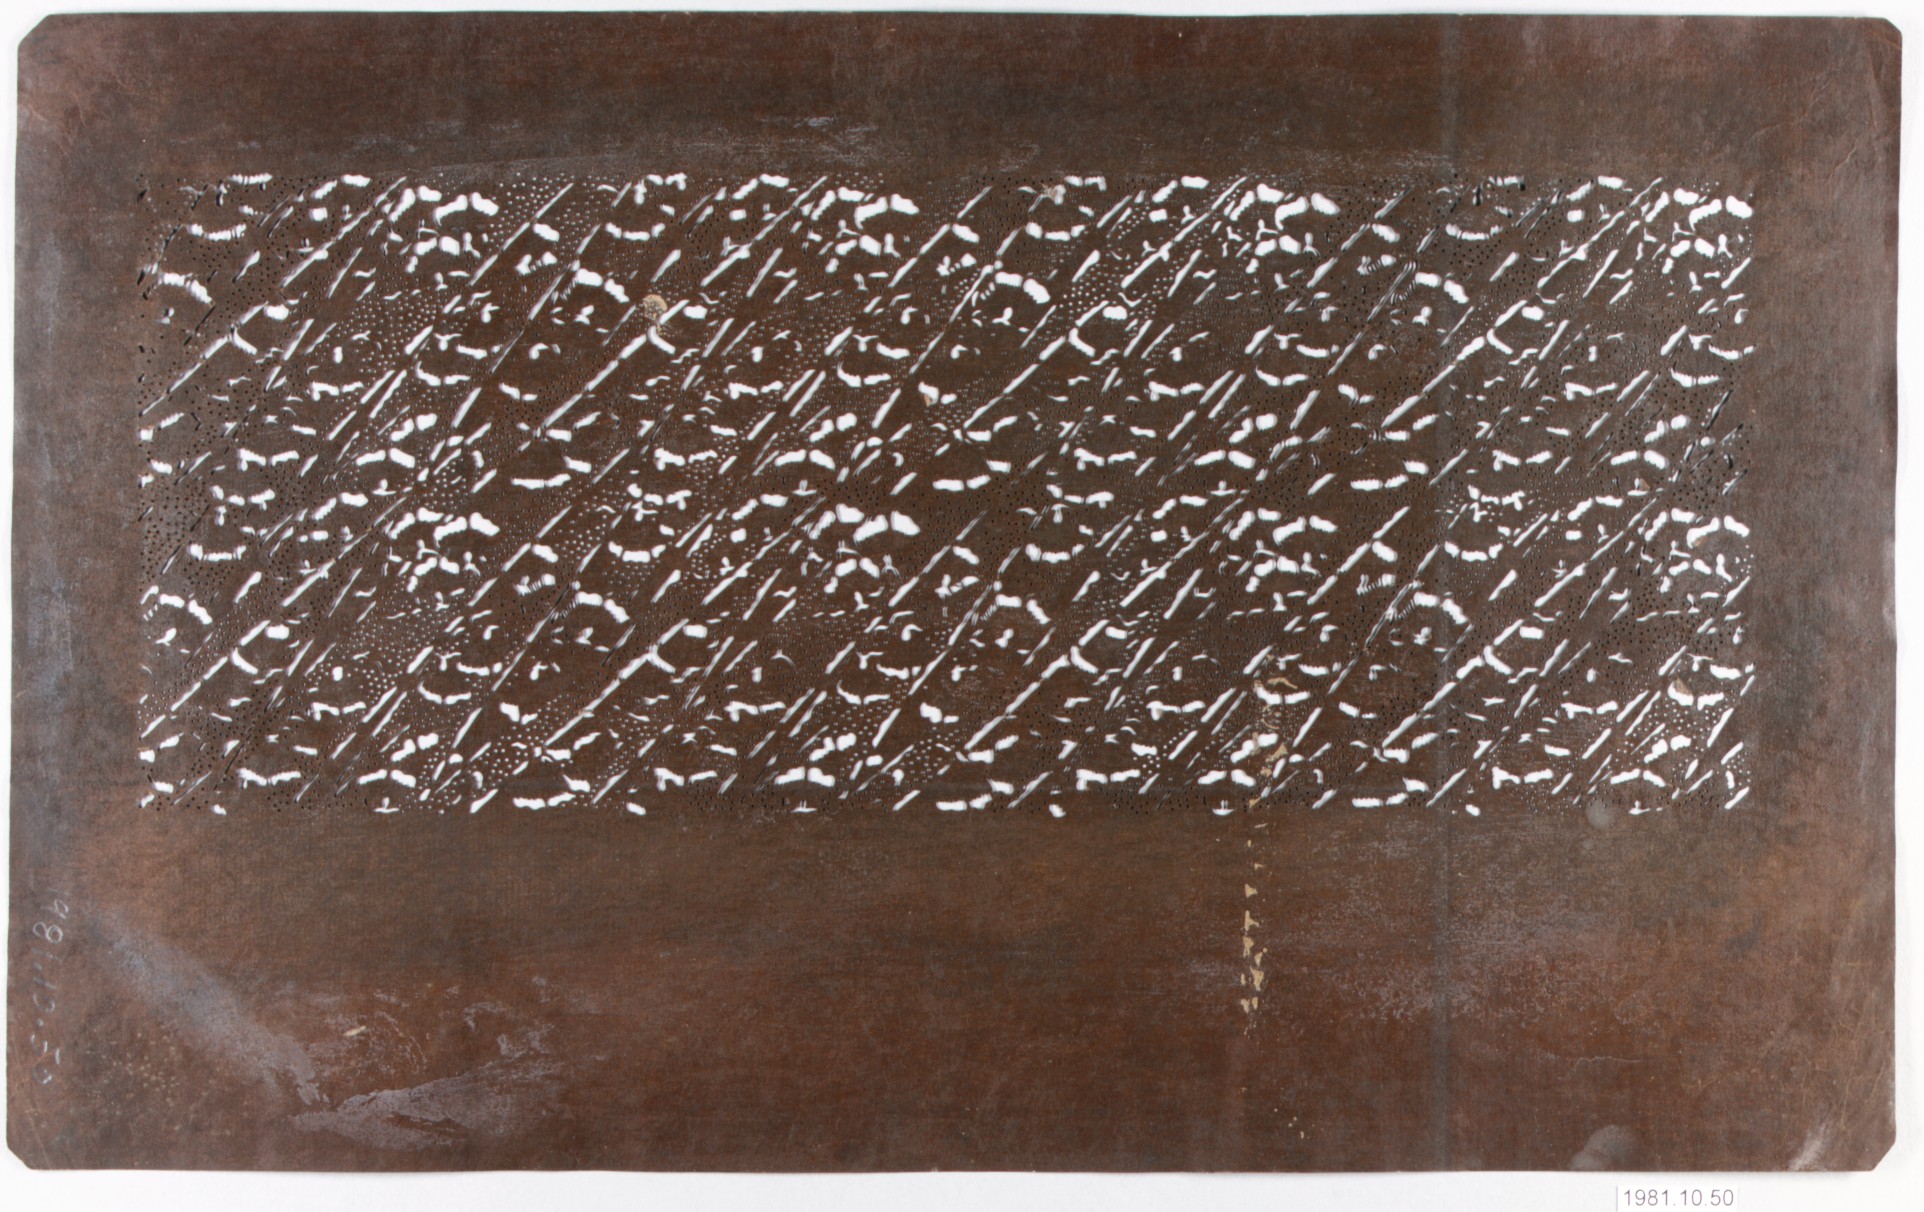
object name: stencil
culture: japanese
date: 1801-1900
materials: paper